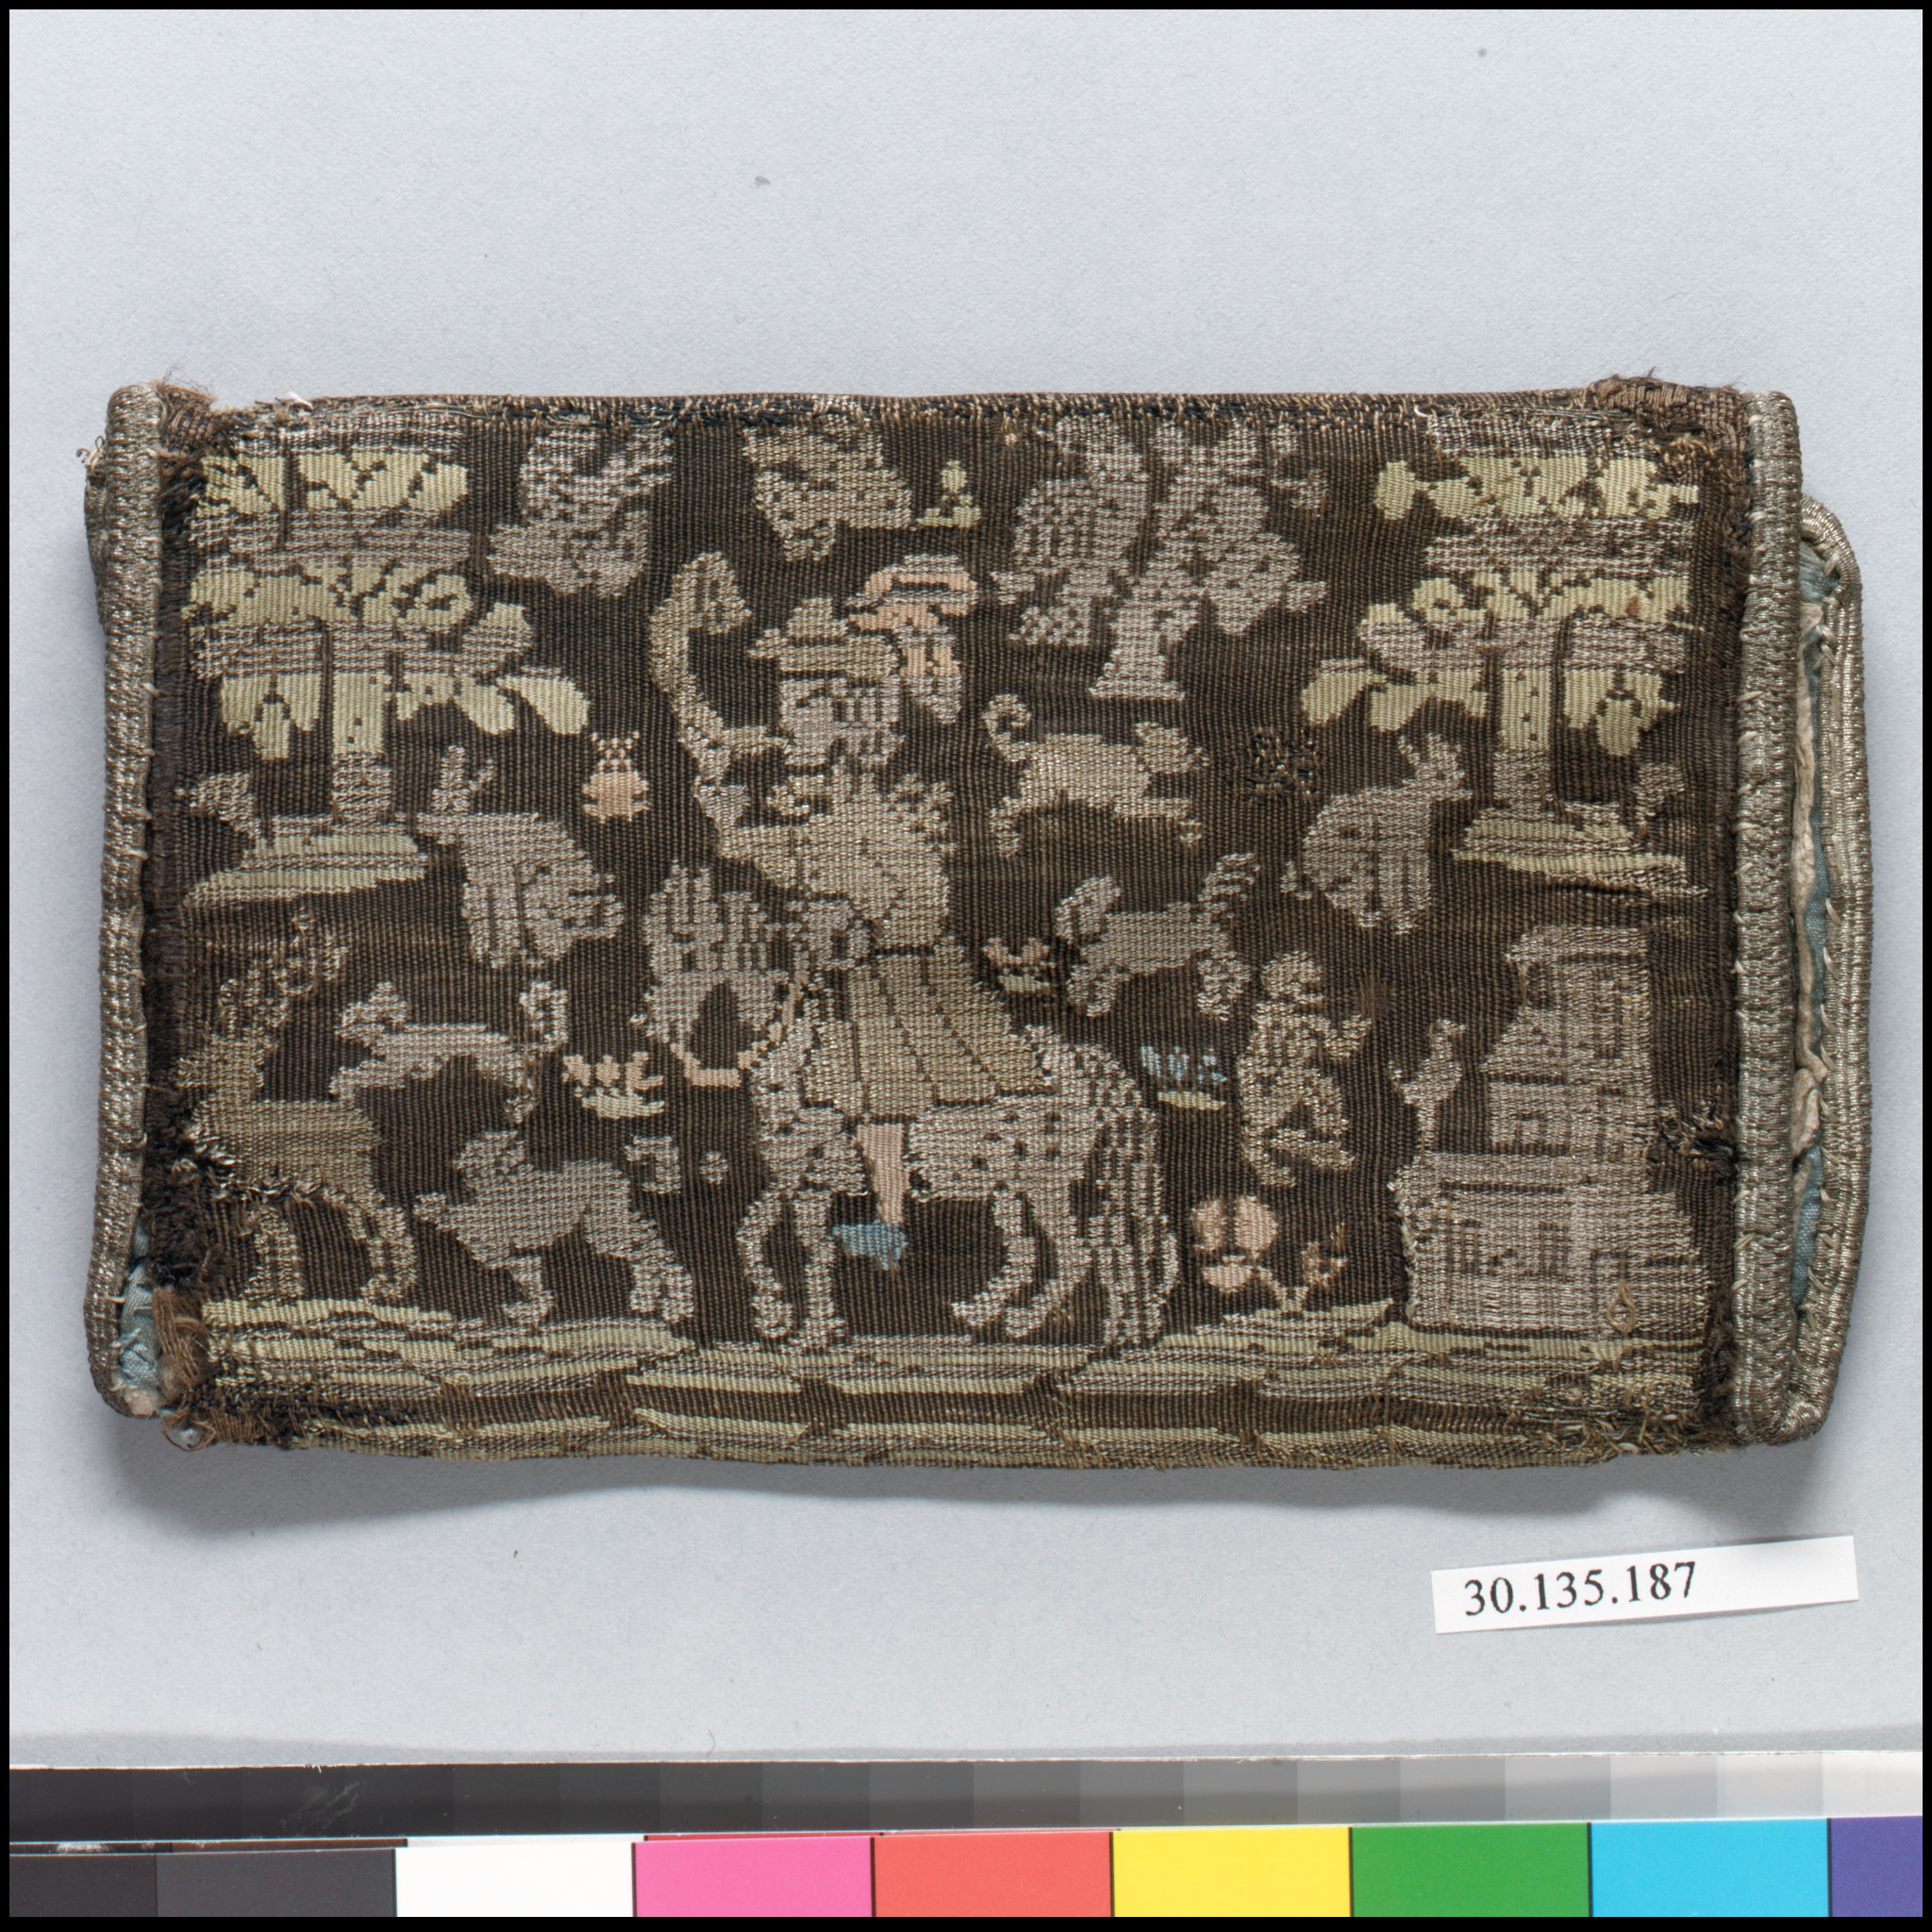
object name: letter case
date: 1601-1733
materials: metal thread, silk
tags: human figures,animals,horses